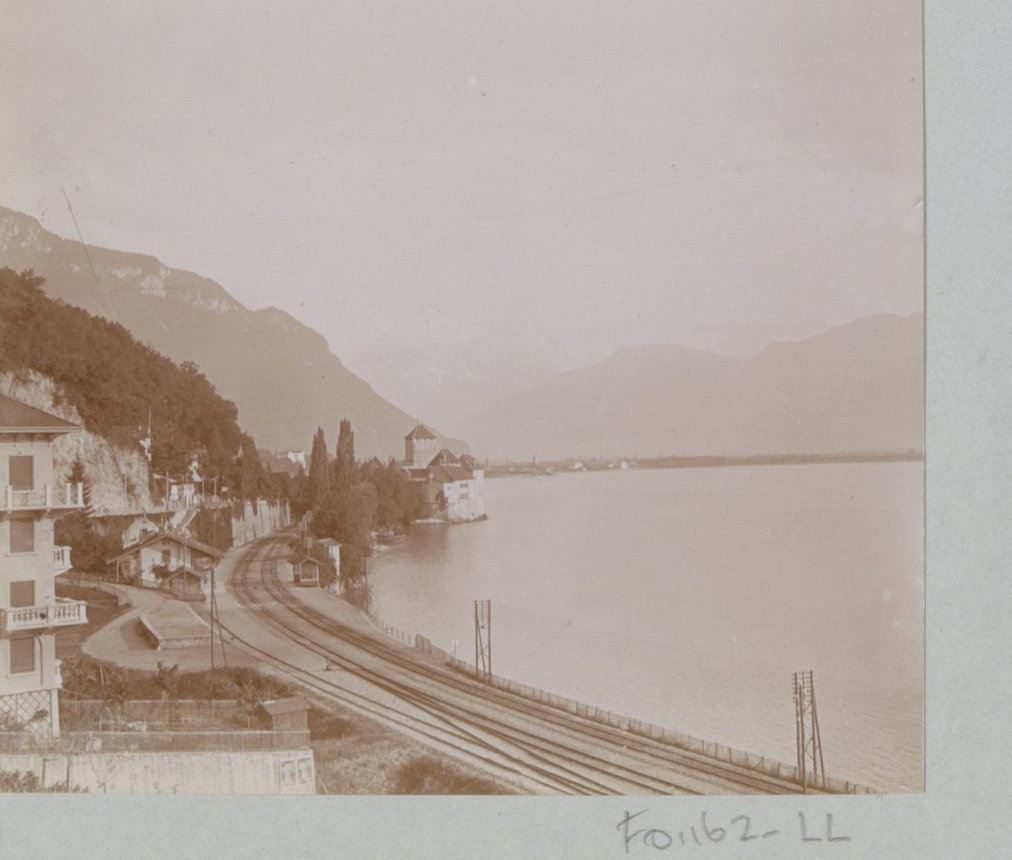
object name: photograph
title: Gezicht op het Kasteel van Chillon aan het Meer van Genève met op de voorgrond spoorlijnen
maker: Anonymous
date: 1905-1910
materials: paper, photographic support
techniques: gelatin silver print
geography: lake geneva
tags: castle, lake, railway, train, mountain-range, snow peaks, switzerland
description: Onderdeel van Fotoalbum van een Franse amateurfotograaf met bezienswaardigheden in Frankrijk, Zwitserland en Italië.